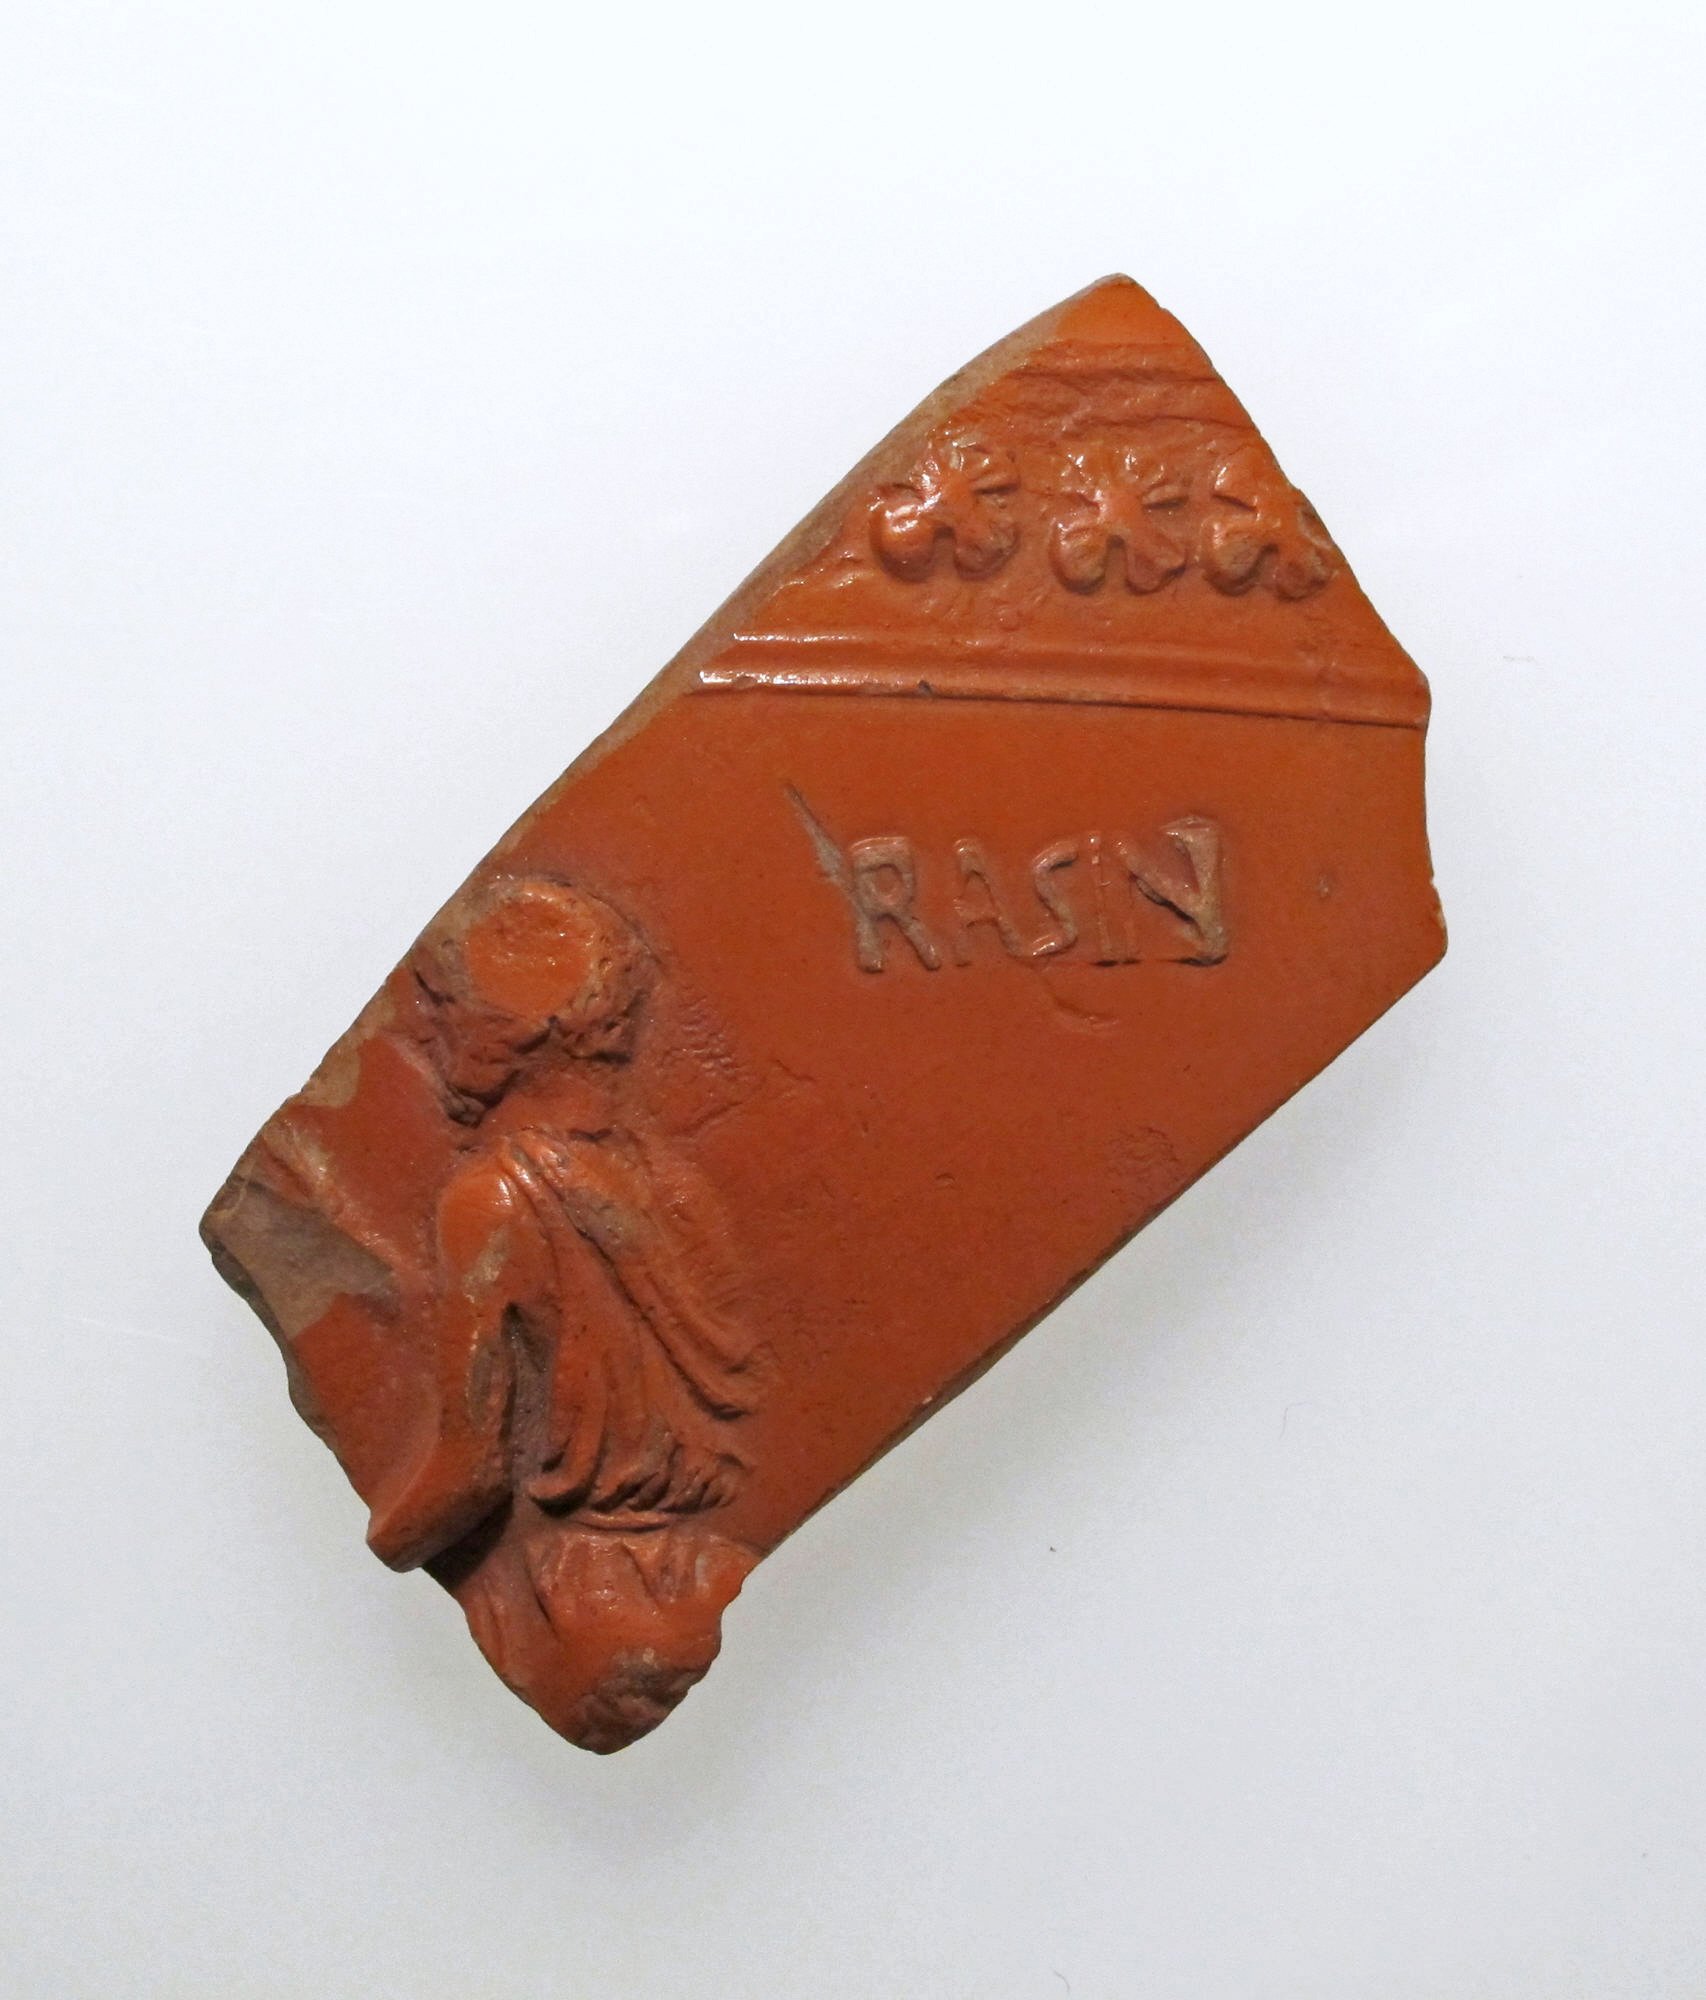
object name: vase fragment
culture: roman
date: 100 BCE-100 CE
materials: terracotta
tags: men